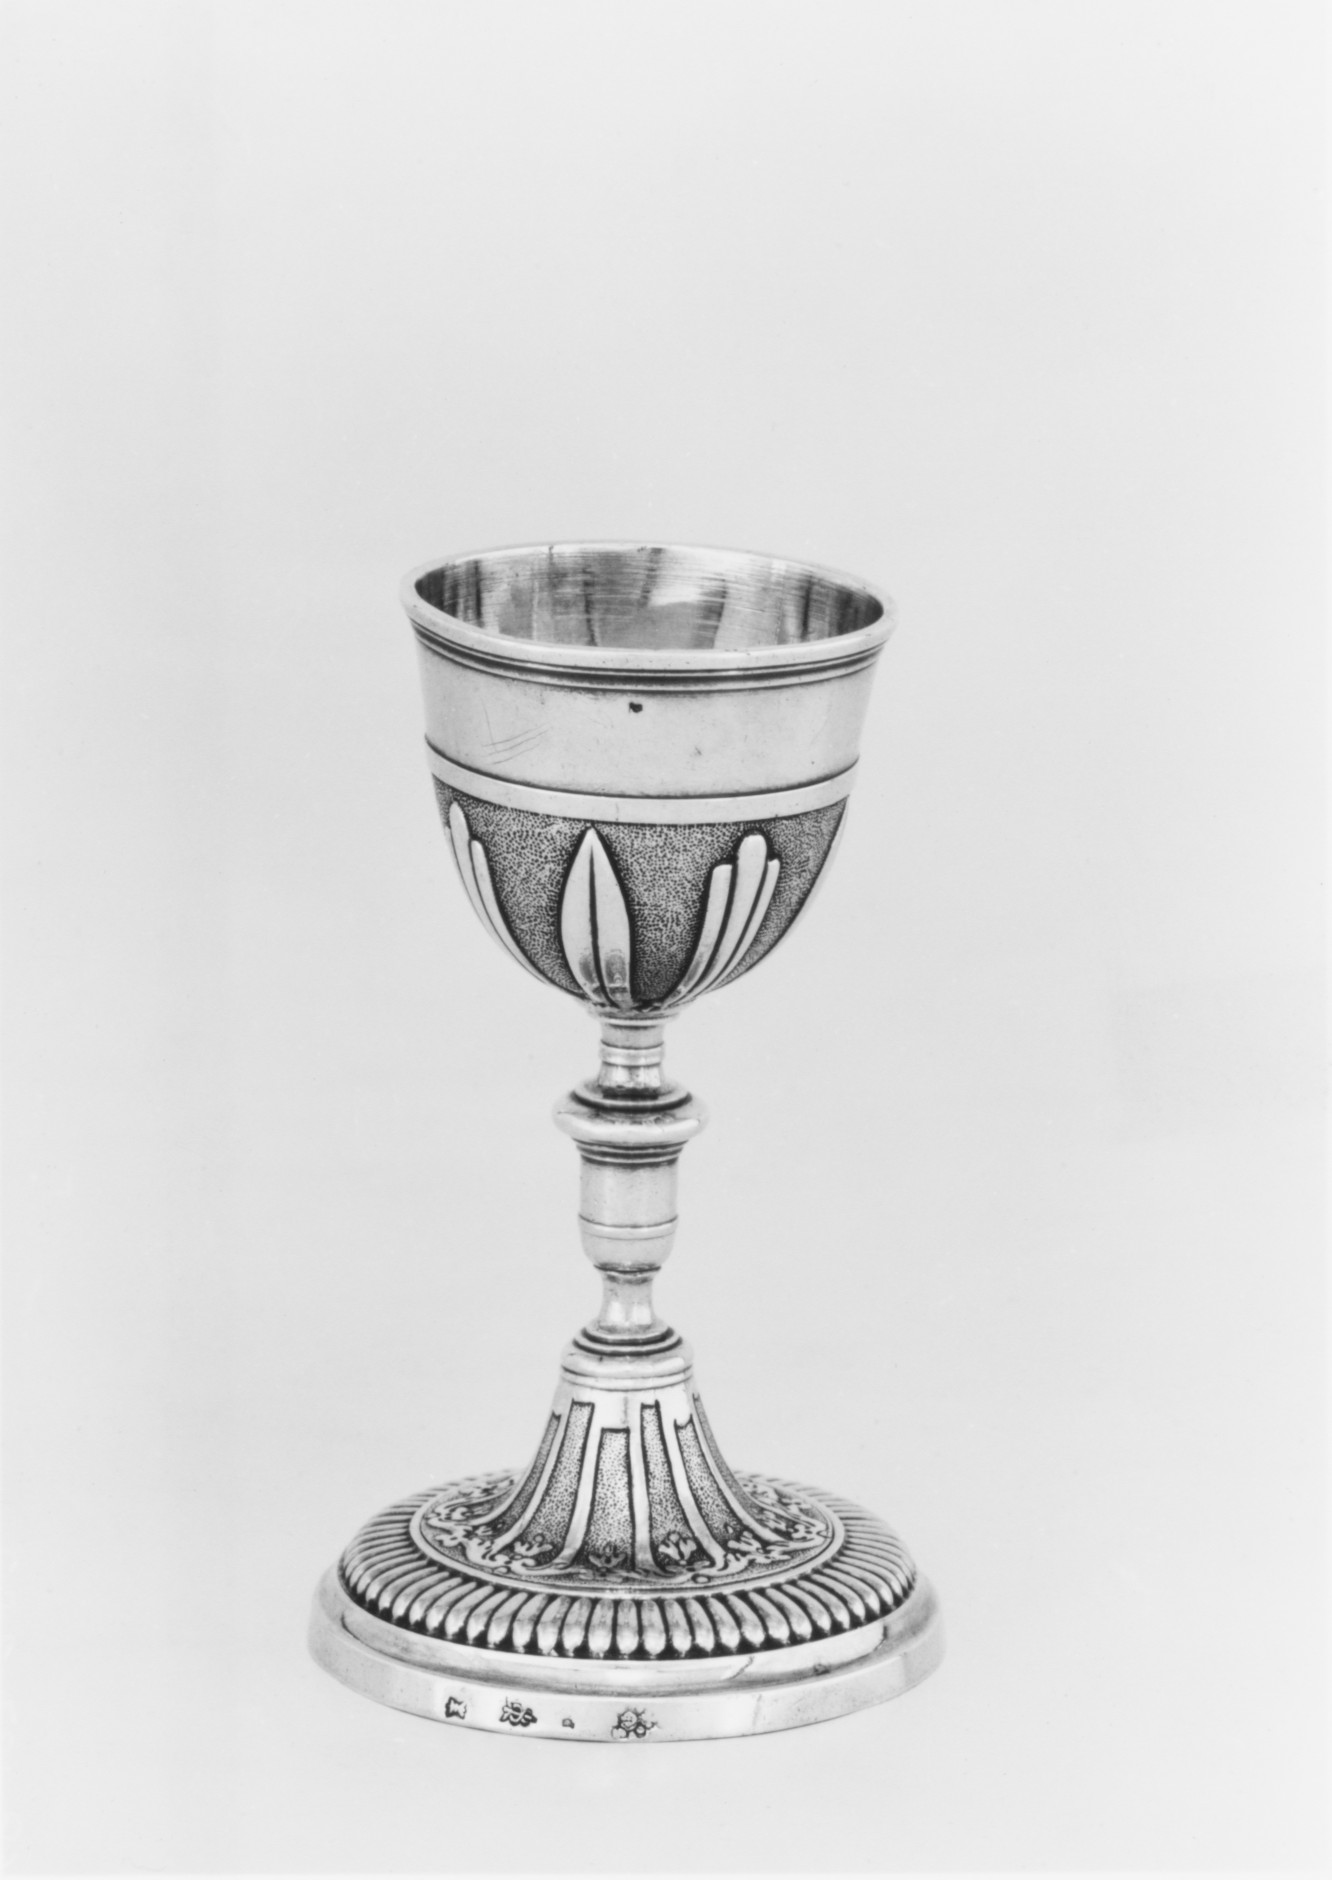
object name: egg cup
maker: pierre soulaine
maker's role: maker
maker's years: 1659-1759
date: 1725-1726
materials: silver